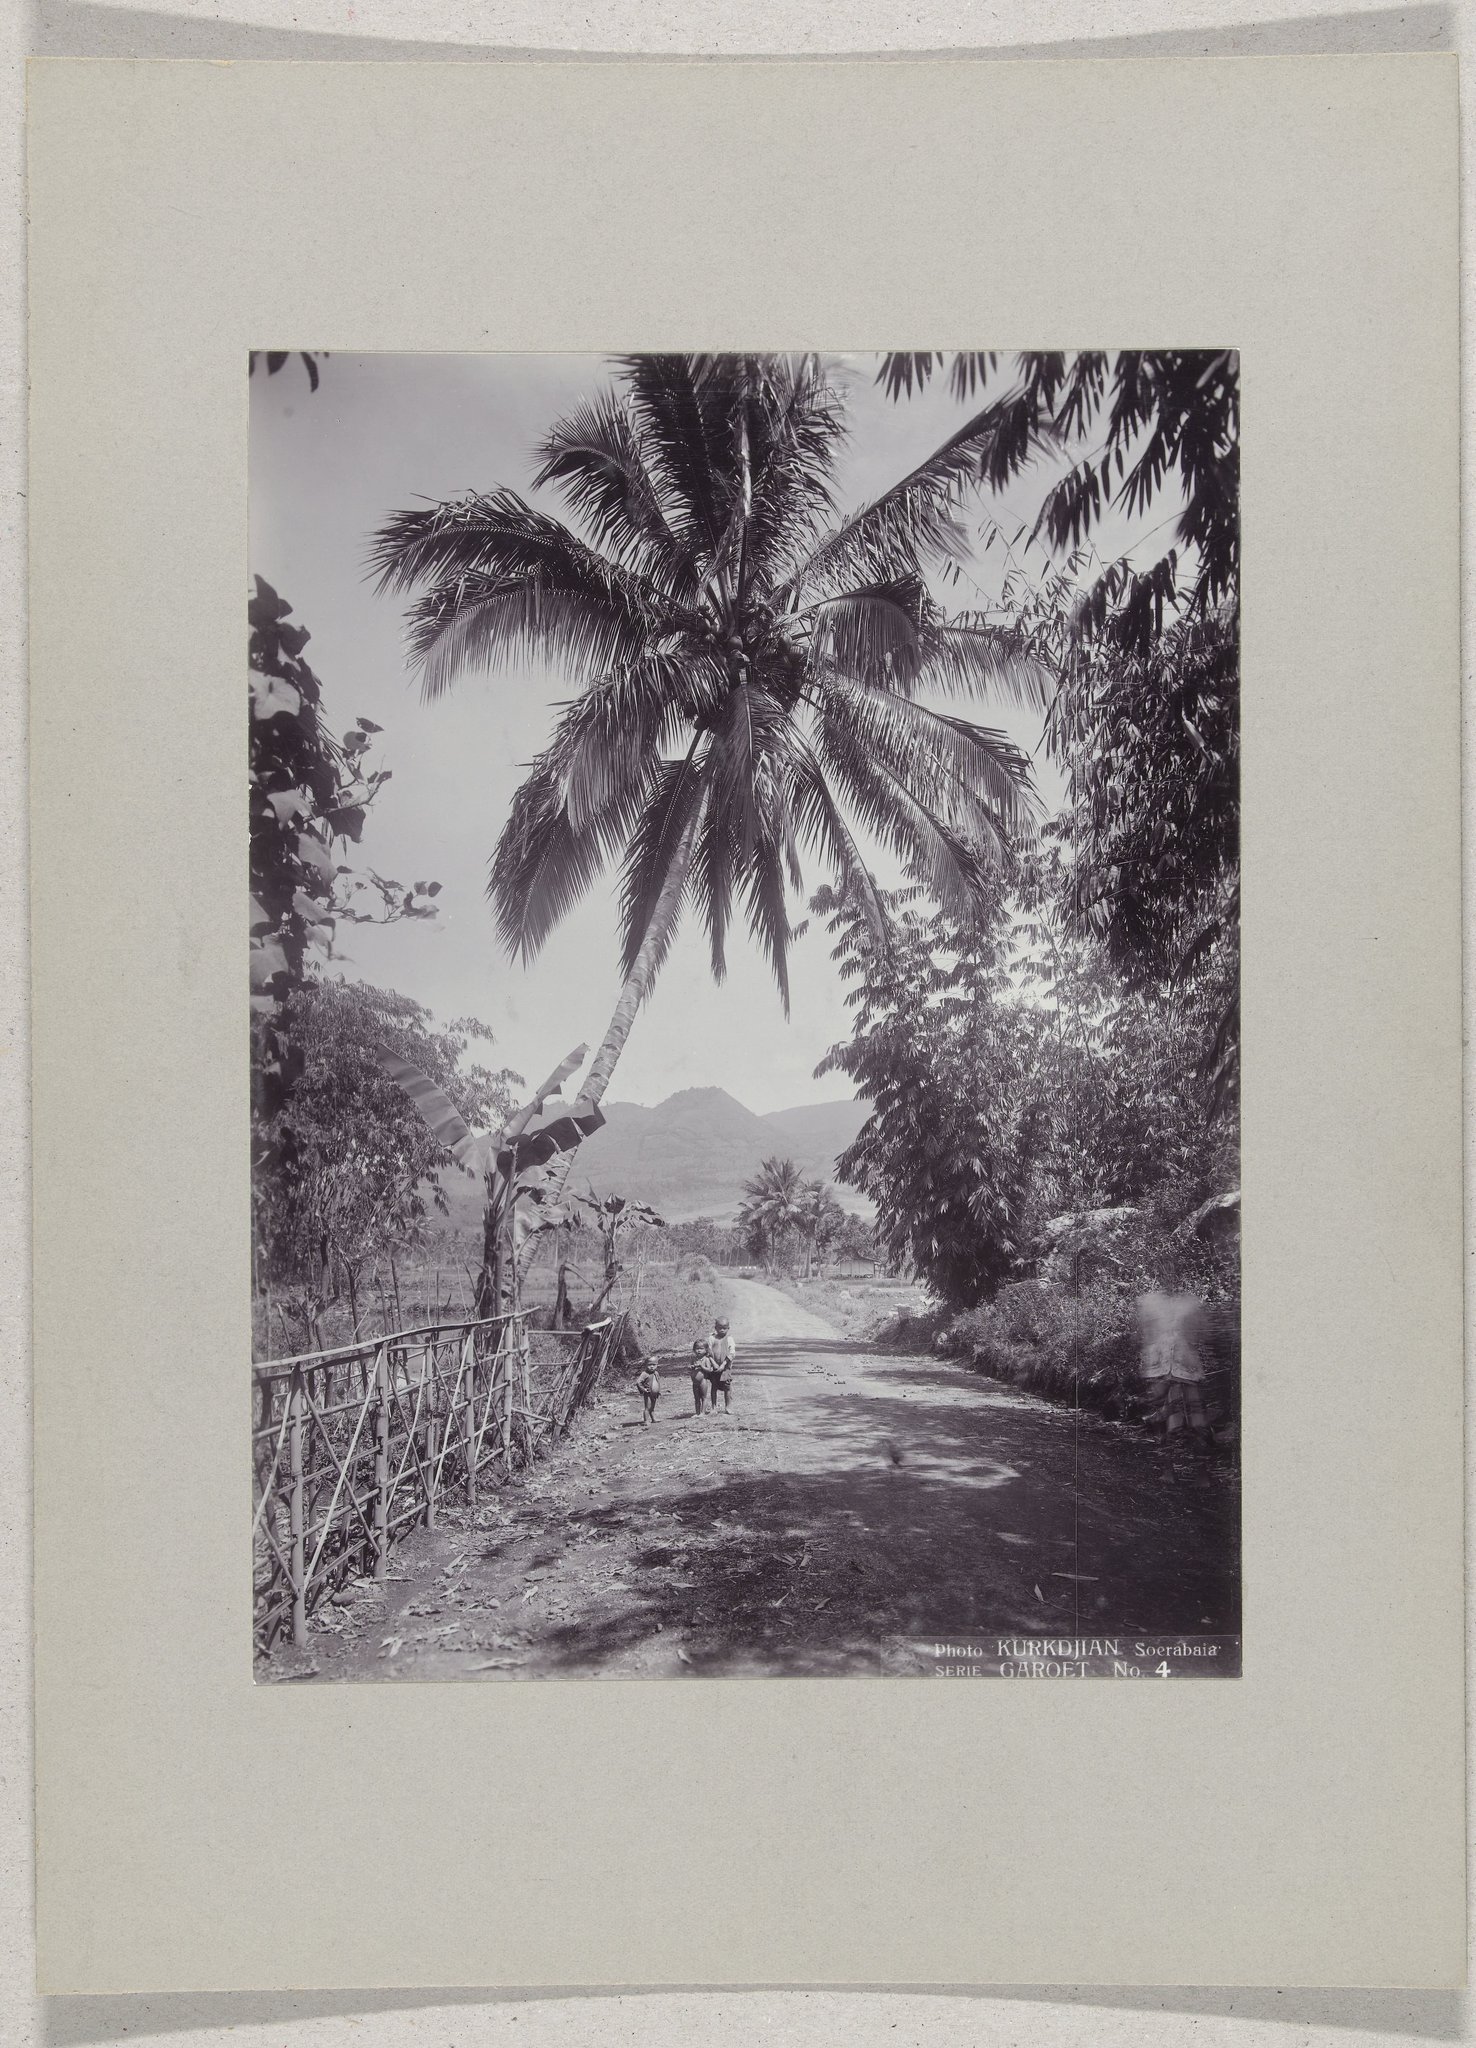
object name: photograph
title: Drie kinderen op een weg bij Garoet, Nederlands-Indië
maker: onnes kurkdjian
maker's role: fotograaf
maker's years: 1851-1903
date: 1895-1915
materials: cardboard, paper, photographic support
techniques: gelatin silver print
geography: garut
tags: indonesia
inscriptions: name: ‘Photo Kurkdjian Soerabaia / Serie Garoet No. 4’, number: ‘64’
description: Drie kinderen op een weg bij Garoet, Nederlands-Indië.